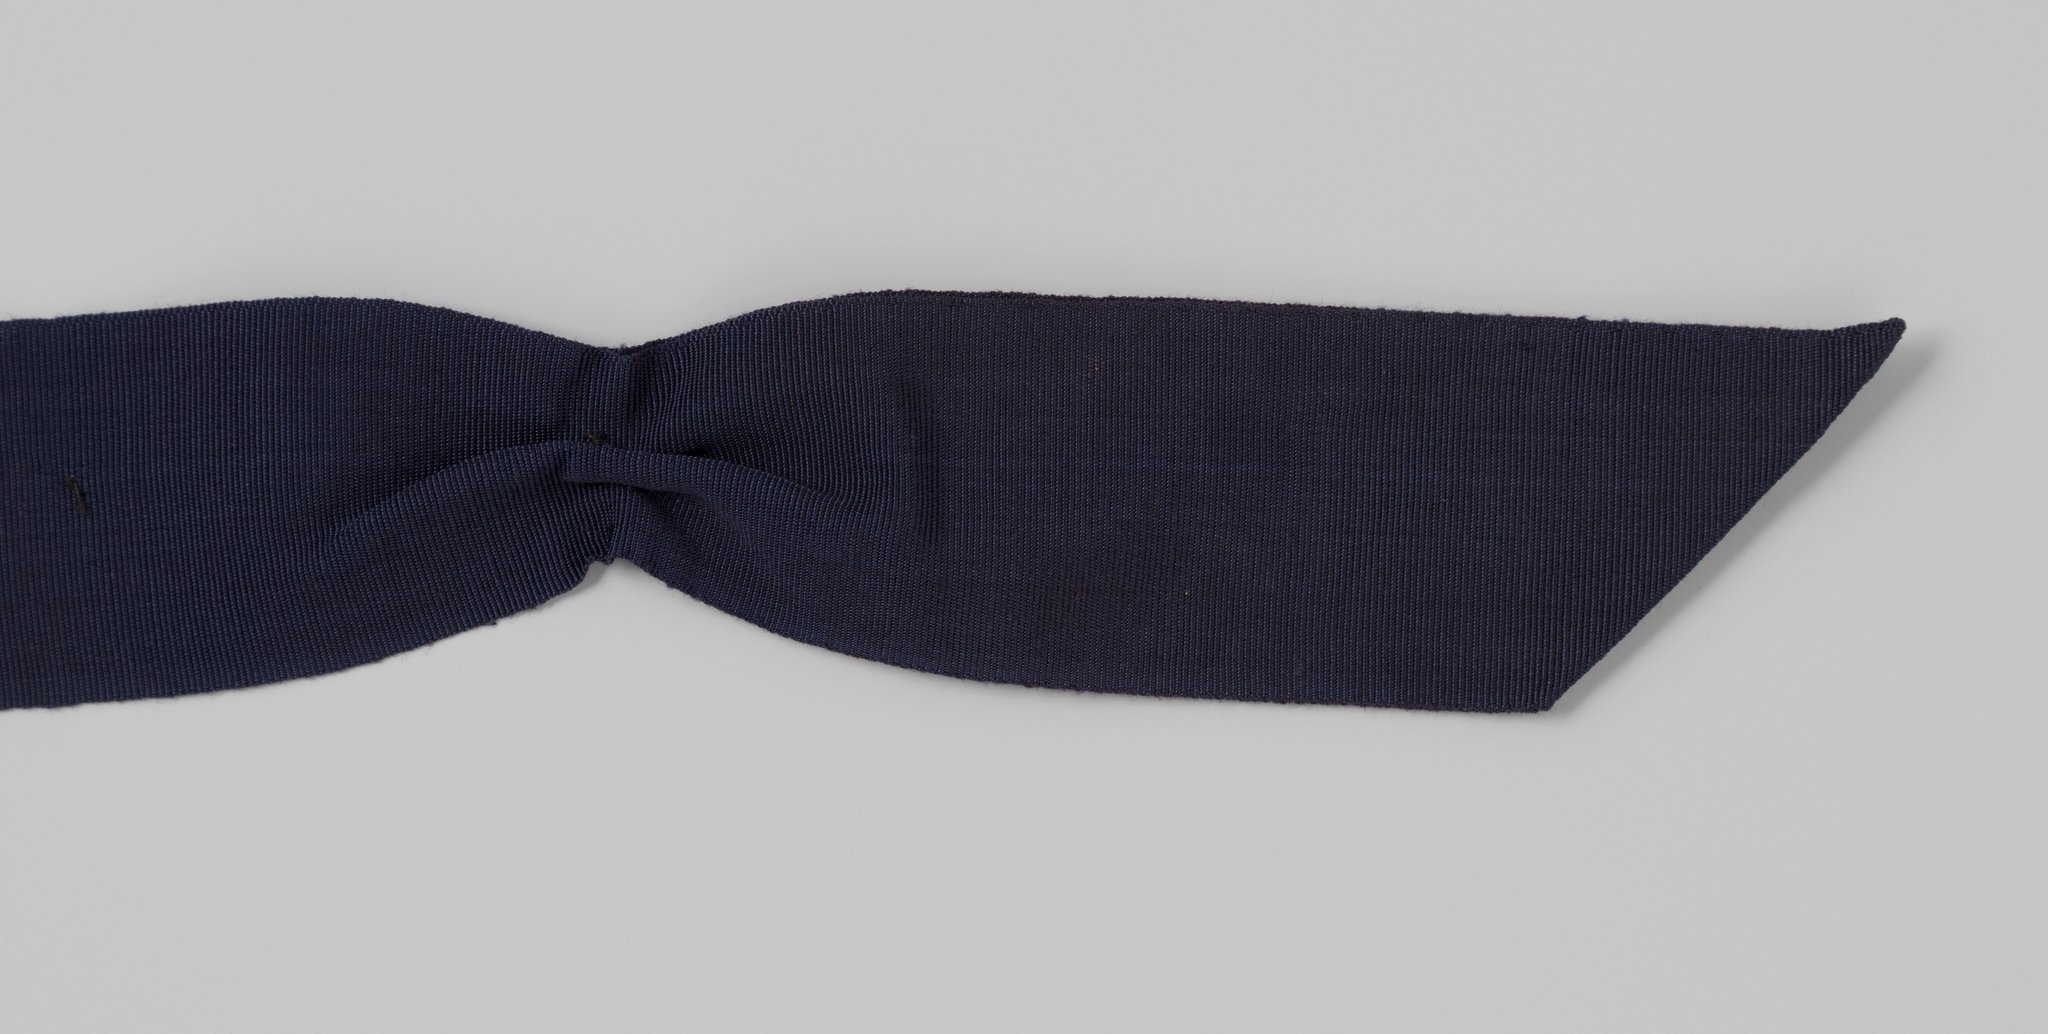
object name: ribbon material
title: Lint, marine rips, aan één van de uiteinden in de lengte dubbelgevouwen en gerimpeld vastgezet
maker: Anonymous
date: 1900-1950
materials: silk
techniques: cockled, weave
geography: western europe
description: Verzameling zijden linten in terra/wit, arise/bruin, champagne, blauw-wit gestreept, mosgroen, marine, paars en zwart.